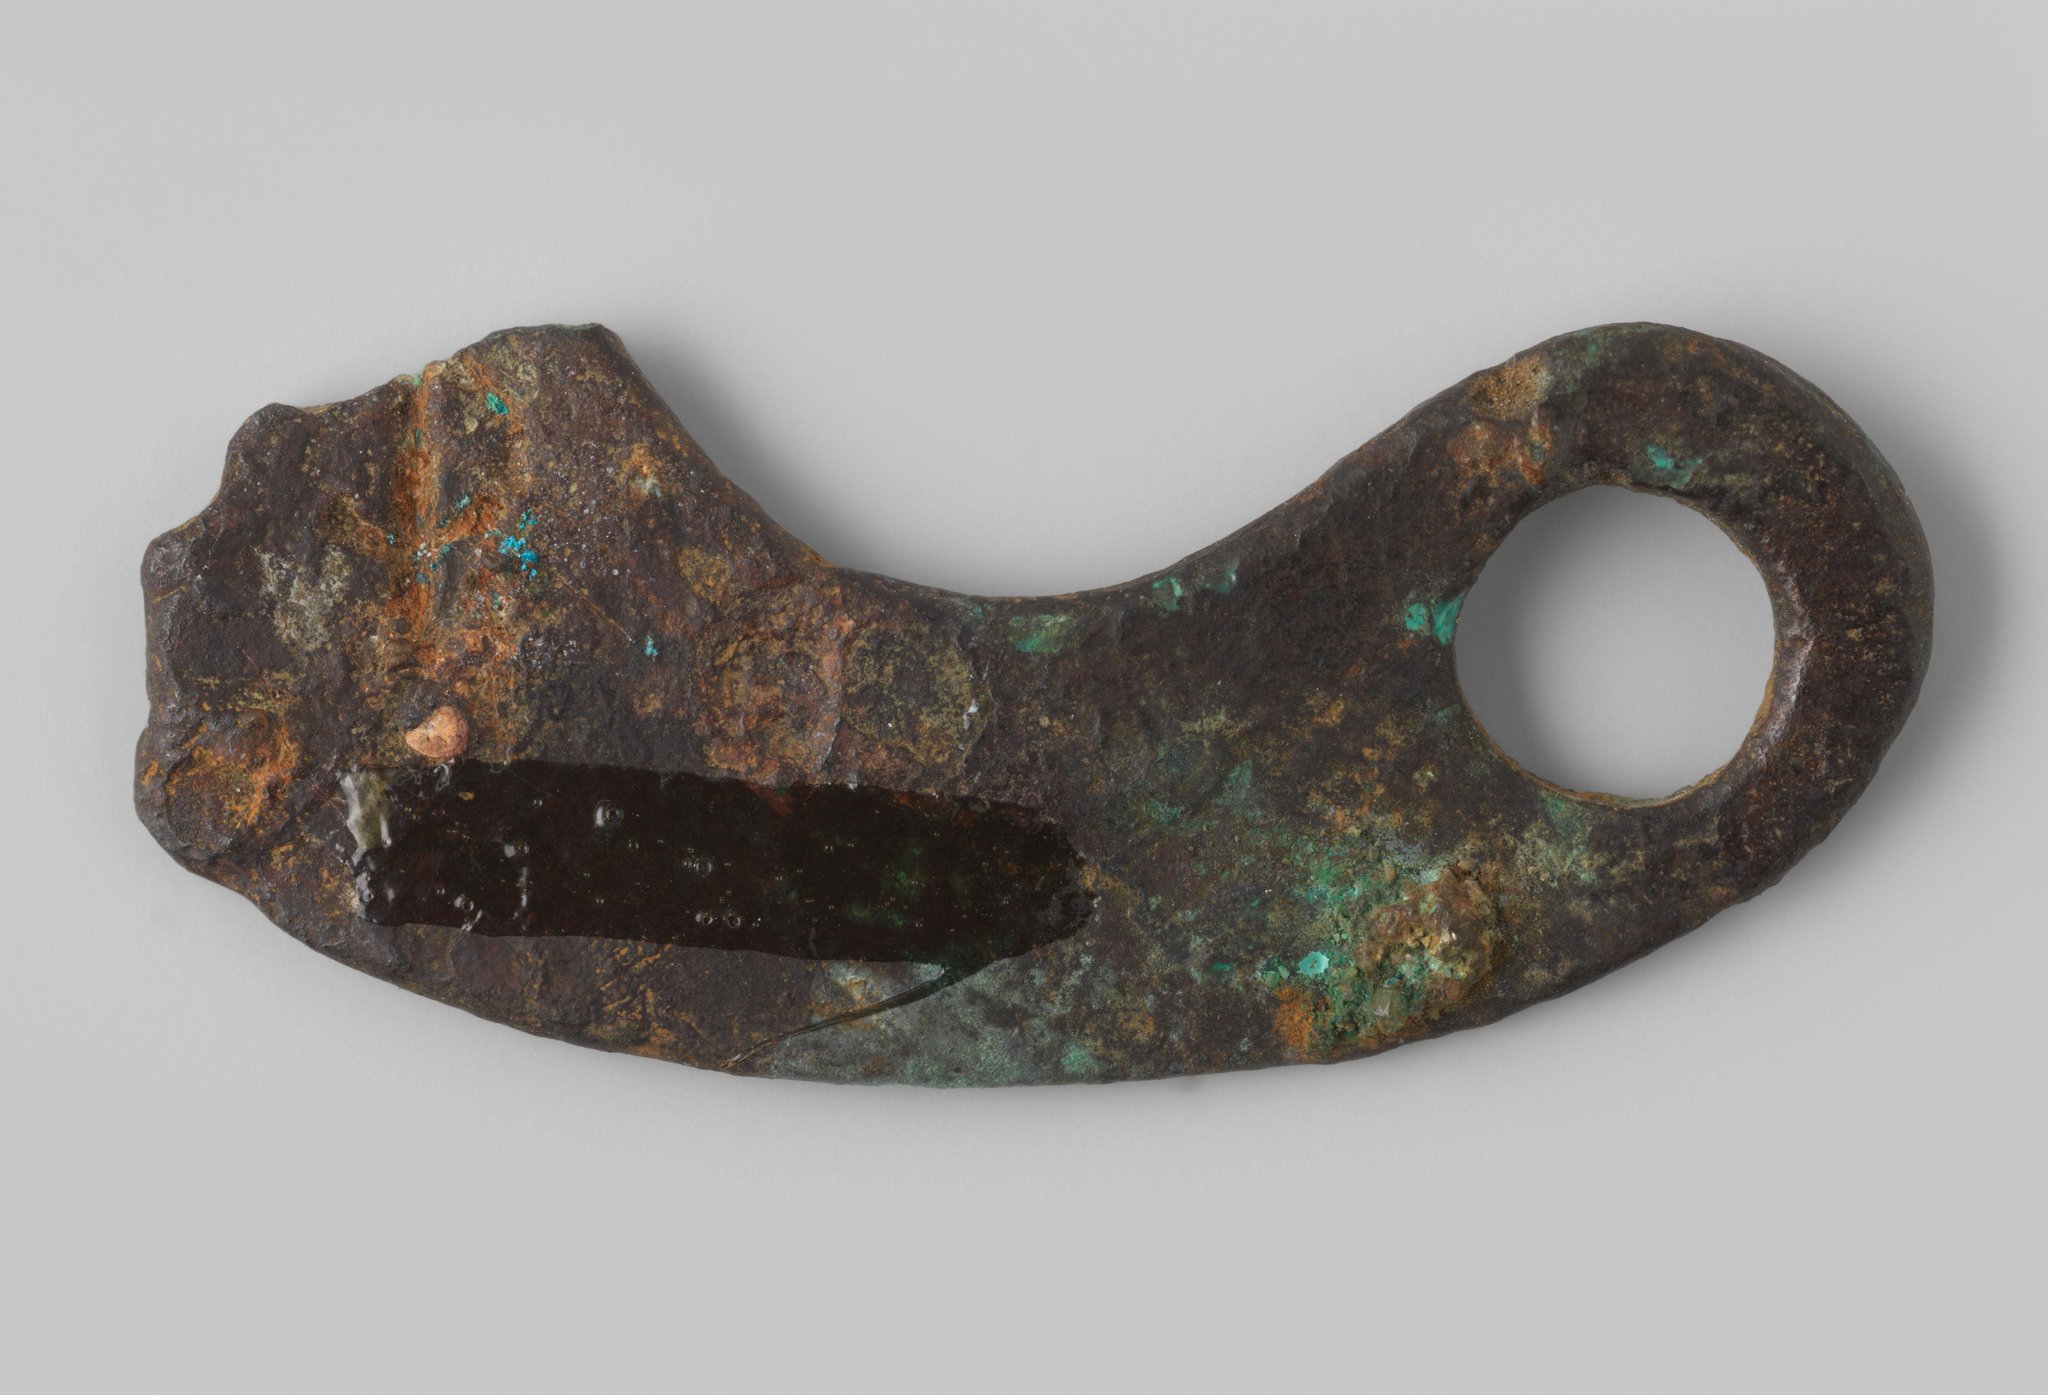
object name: musket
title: Fragment schroefplaat van een musket uit het wrak van de Oost-Indiëvaarder Hollandia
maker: Anonymous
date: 1700-1743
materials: copper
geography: netherlands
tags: verenigde oostindische compagnie, hollandia (schip), annet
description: Fragm, left wing id. NG 1978-74H986, side plate.